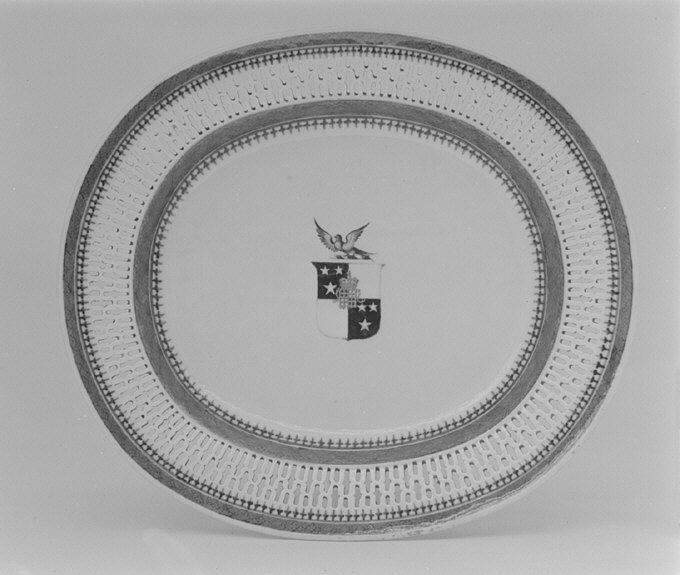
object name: tray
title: Tray (part of a service)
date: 1790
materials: hard paste porcelain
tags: birds,coat of arms